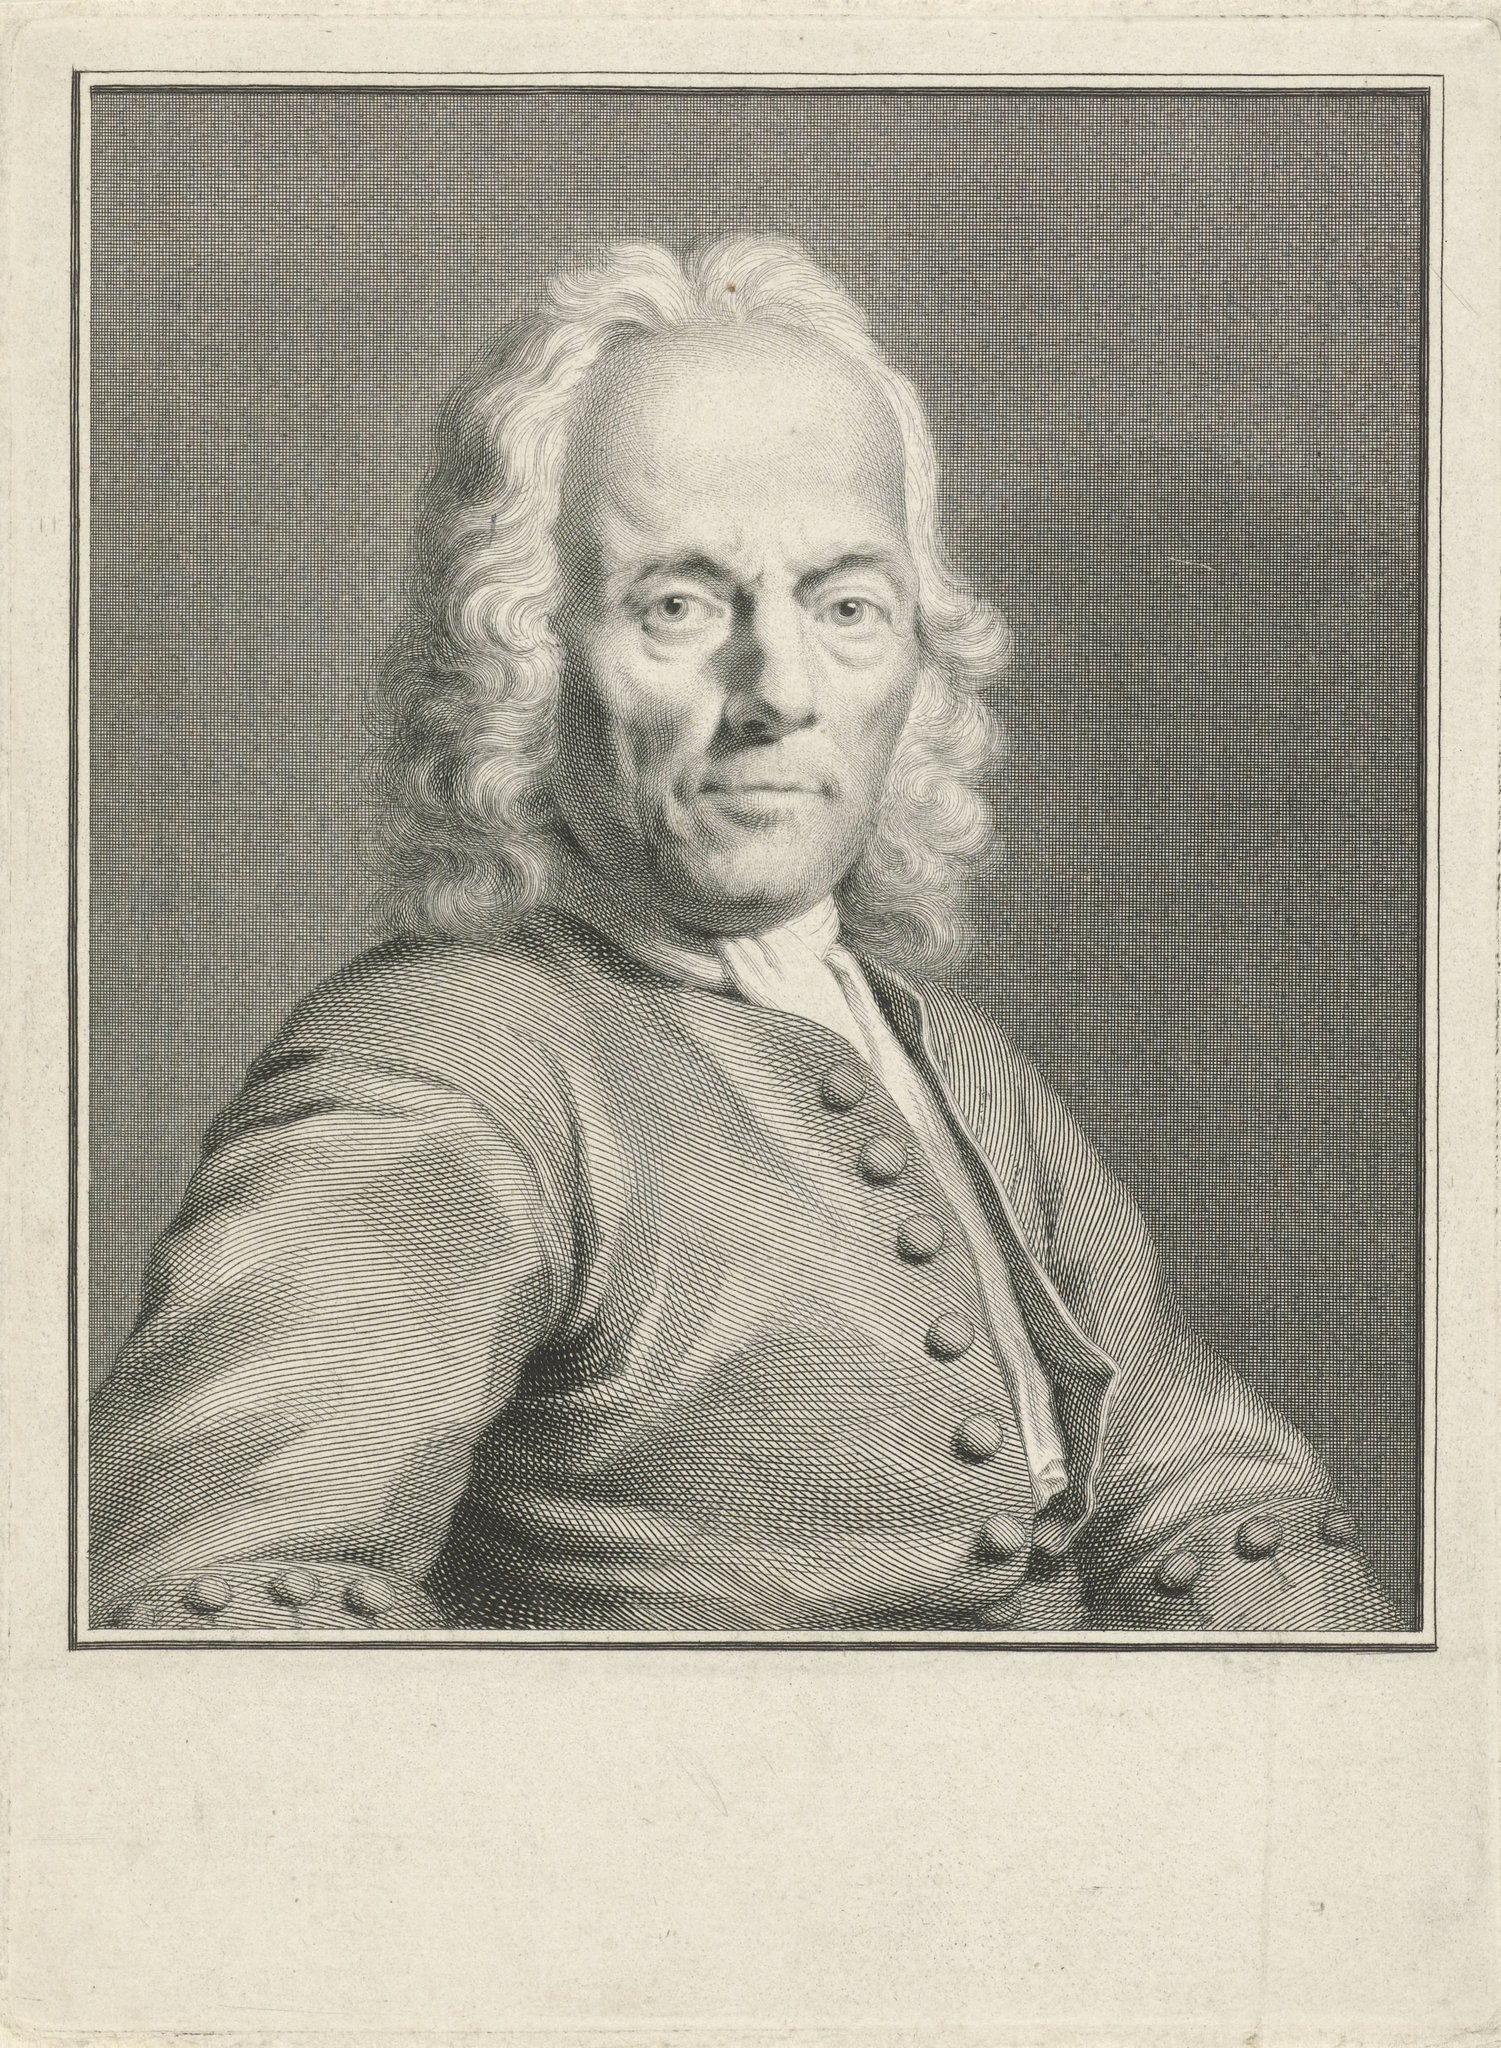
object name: print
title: Portret van Simon Eikelenberg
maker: jacob houbraken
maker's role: draughtsman, print maker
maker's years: 1698-1780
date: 1738-1780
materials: paper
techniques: engraving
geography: amsterdam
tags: painter, draughtsman, simon eikelenberg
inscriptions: collector's mark: Lugt 2228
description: Portret ten halven lijve naar rechts van Simon Eikelenberg.